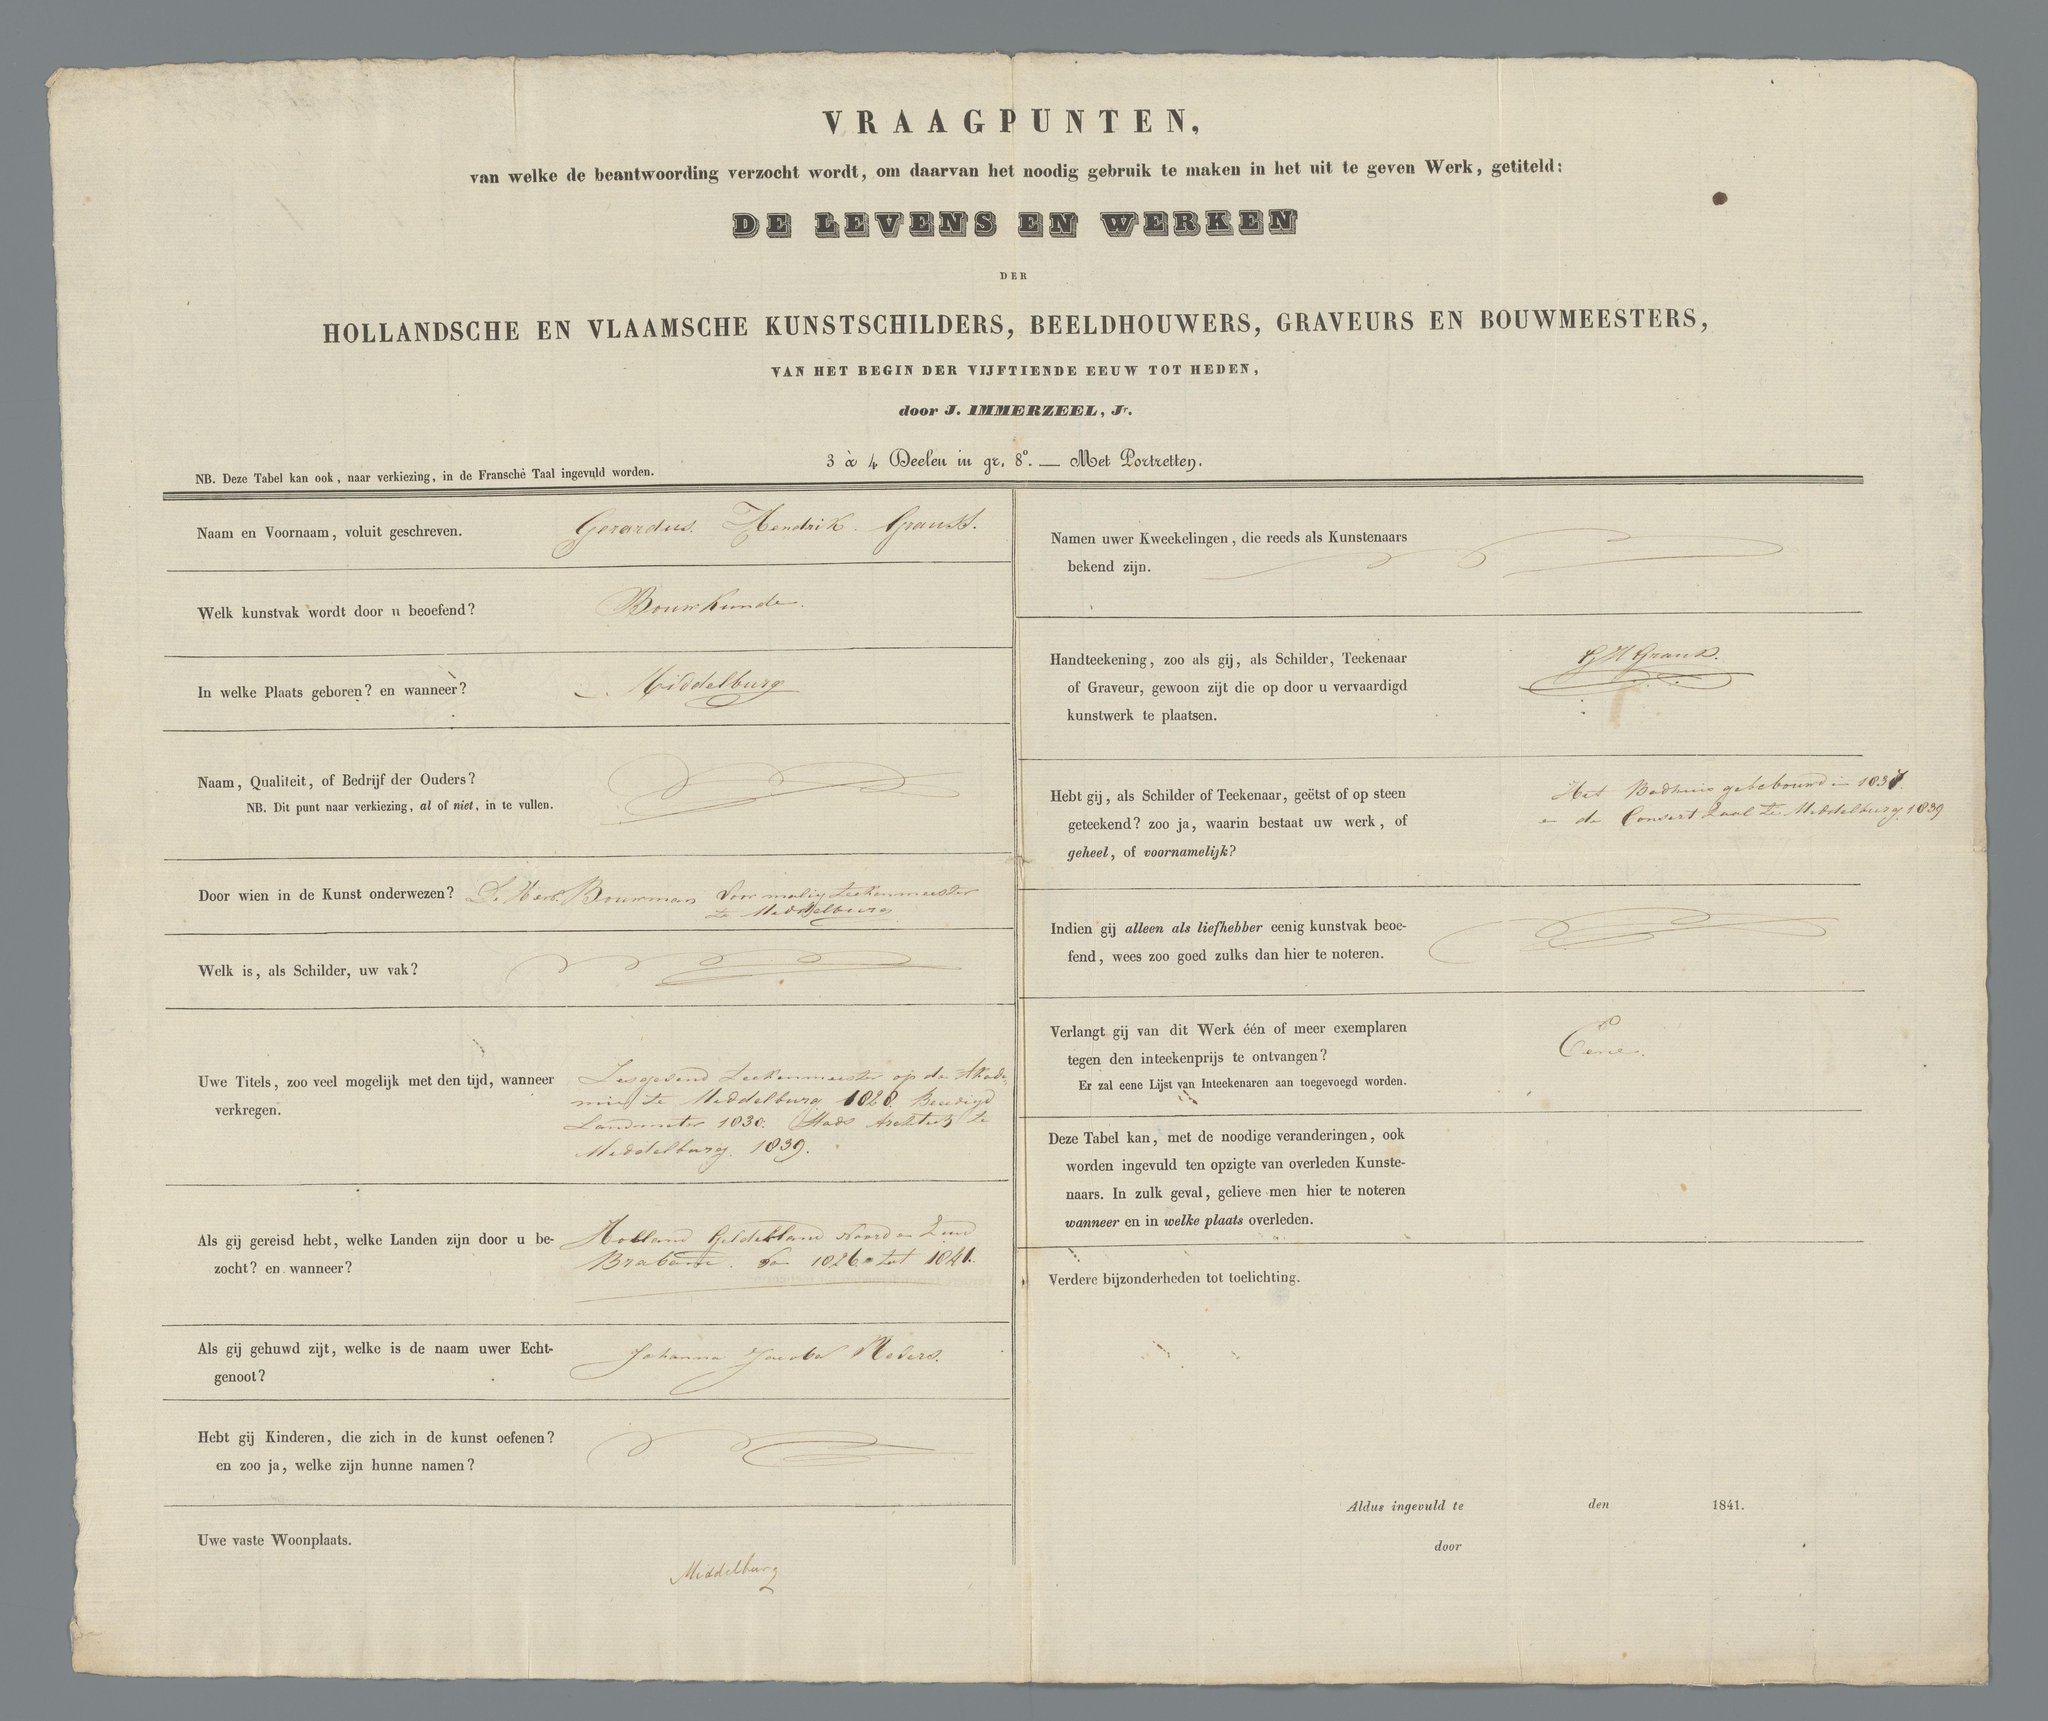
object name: questionnaire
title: Enquêteformulier ingevuld door Gerardus Hendrik Grauss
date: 1840-1843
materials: ink, paper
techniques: pen, printing, writing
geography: middelburg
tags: gerardus hendrik grauss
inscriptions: watermark, inscription: ‘Vraagpunten,/ van welke de beantwoording verzocht wordt, om daarvan het noodig gebruik te maken in het uit te geven Werk, getiteld: De levens en werken/ der Hollandsche en Vlaamsche kunstschilders, beeldhouwers,/ graveurs en bouwmeesters, van het begin der vijftiende eeuw tot heden/ door J. Immerzeel, Jr.’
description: Geplaatst in: Immerzeel, J. Jr., De levens en werken der Hollandsche en Vlaamsche kunstschilders, beeldhouwers, graveurs en bouwmeesters, van het begin der vijftiende eeuw tot heden, Amsterdam: J.C. van Kesteren, 1842-1843.